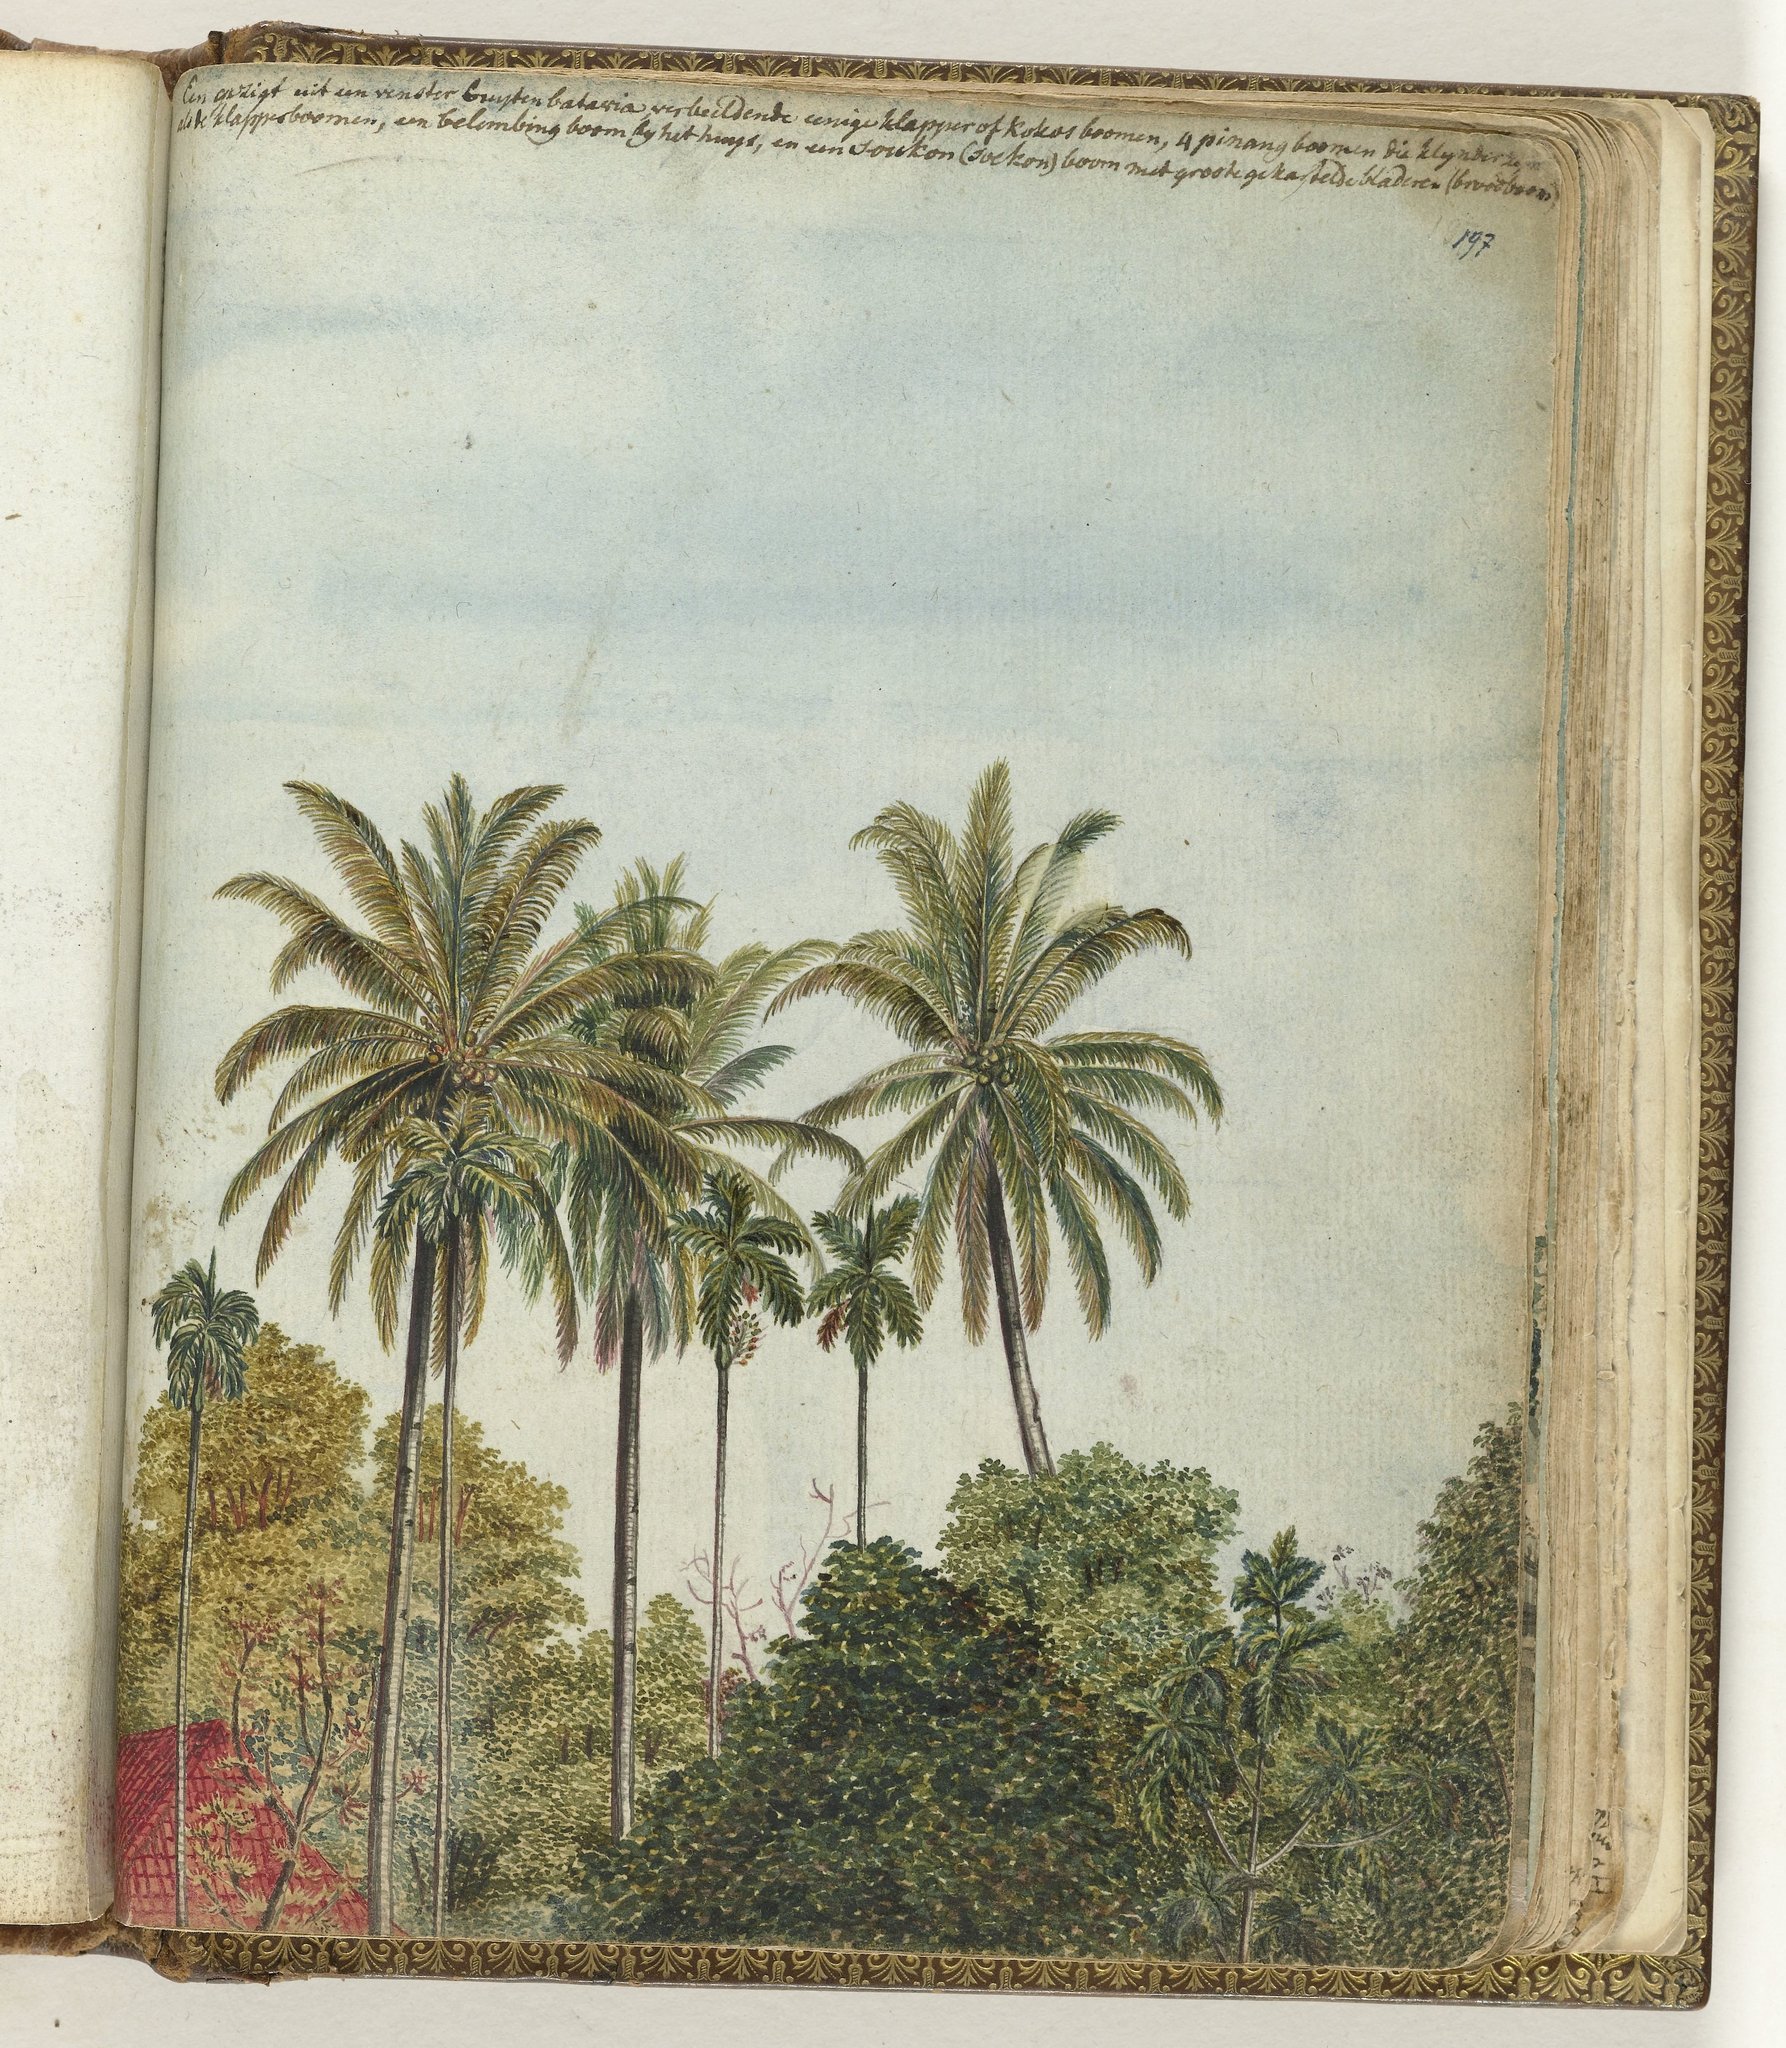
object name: drawing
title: Gezicht uit het venster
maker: jan brandes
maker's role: draughtsman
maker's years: 1743-1808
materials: paper, pencil, watercolor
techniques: brush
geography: batavia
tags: bodegraven, draughtsman, jan brandes, trees: palm-tree, batavia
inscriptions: inscription: ‘Een gezigt uit een venster buyten Batavia verbeeldende eenige klapper of kokosboomen, 4 pinang boomen, die klynder zyn als de klapperboomen, een belimbing boom by het huys, en een soukon (soekon) boom met groote gekartelde bladeren (broodboom)’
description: Kleurtekening van het gezicht op een bijgebouw van Brandes' huis bij Batavia omringd door bomen. Met opschrift. Onderdeel uit het schetsboek van Jan Brandes, dl. 1 (1808), p. 197.